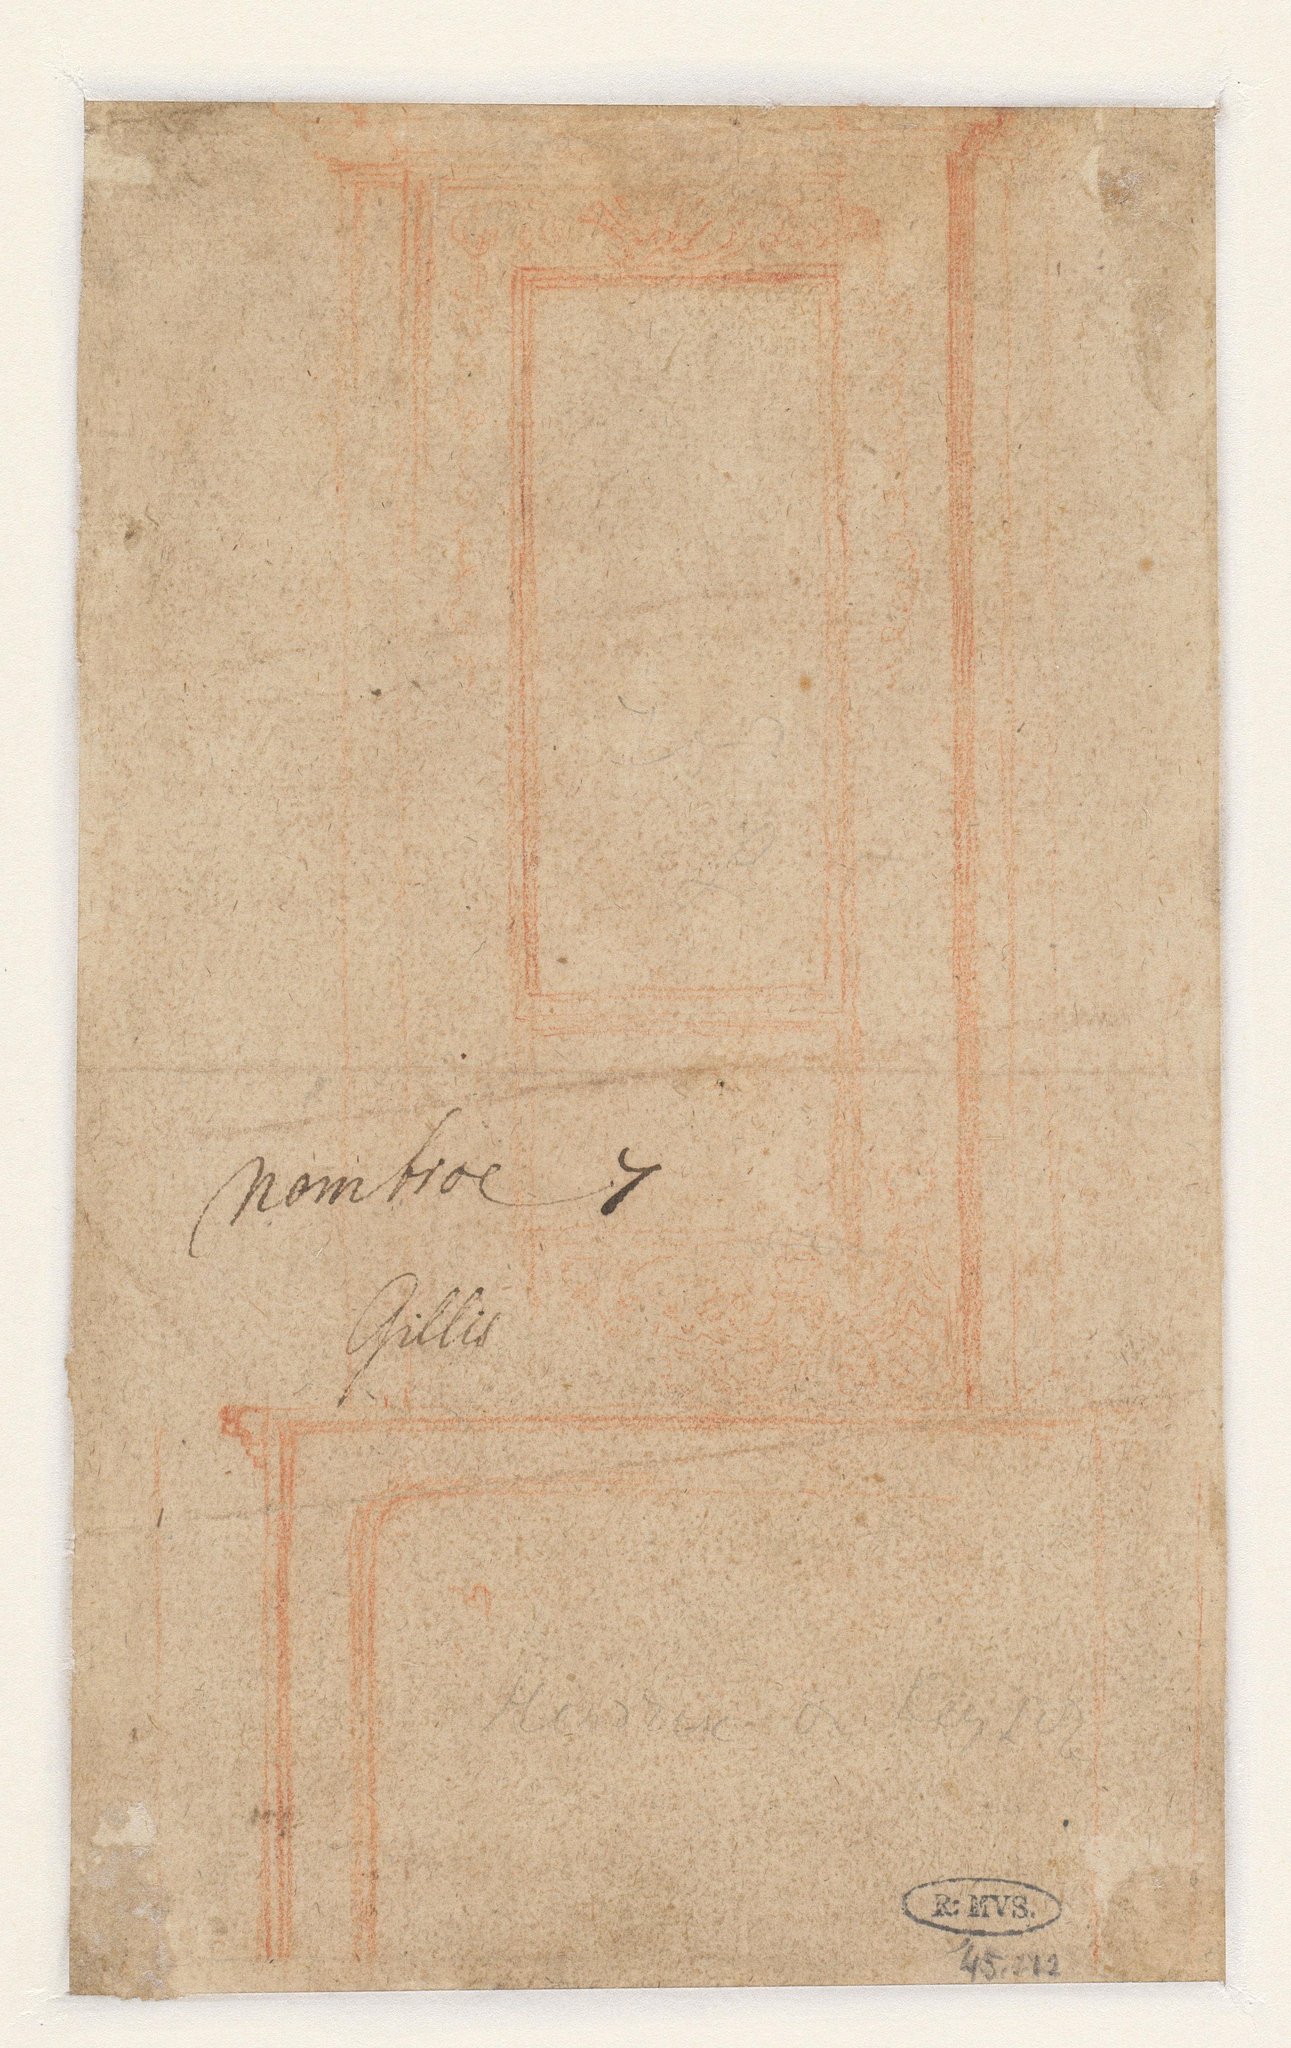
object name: design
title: Ontwerp voor een deuromlijsting of schoorsteenmantel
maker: Anonymous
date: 1600-1699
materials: chalk, paper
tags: architectural detail, ornamenting, decorating ~ applied arts